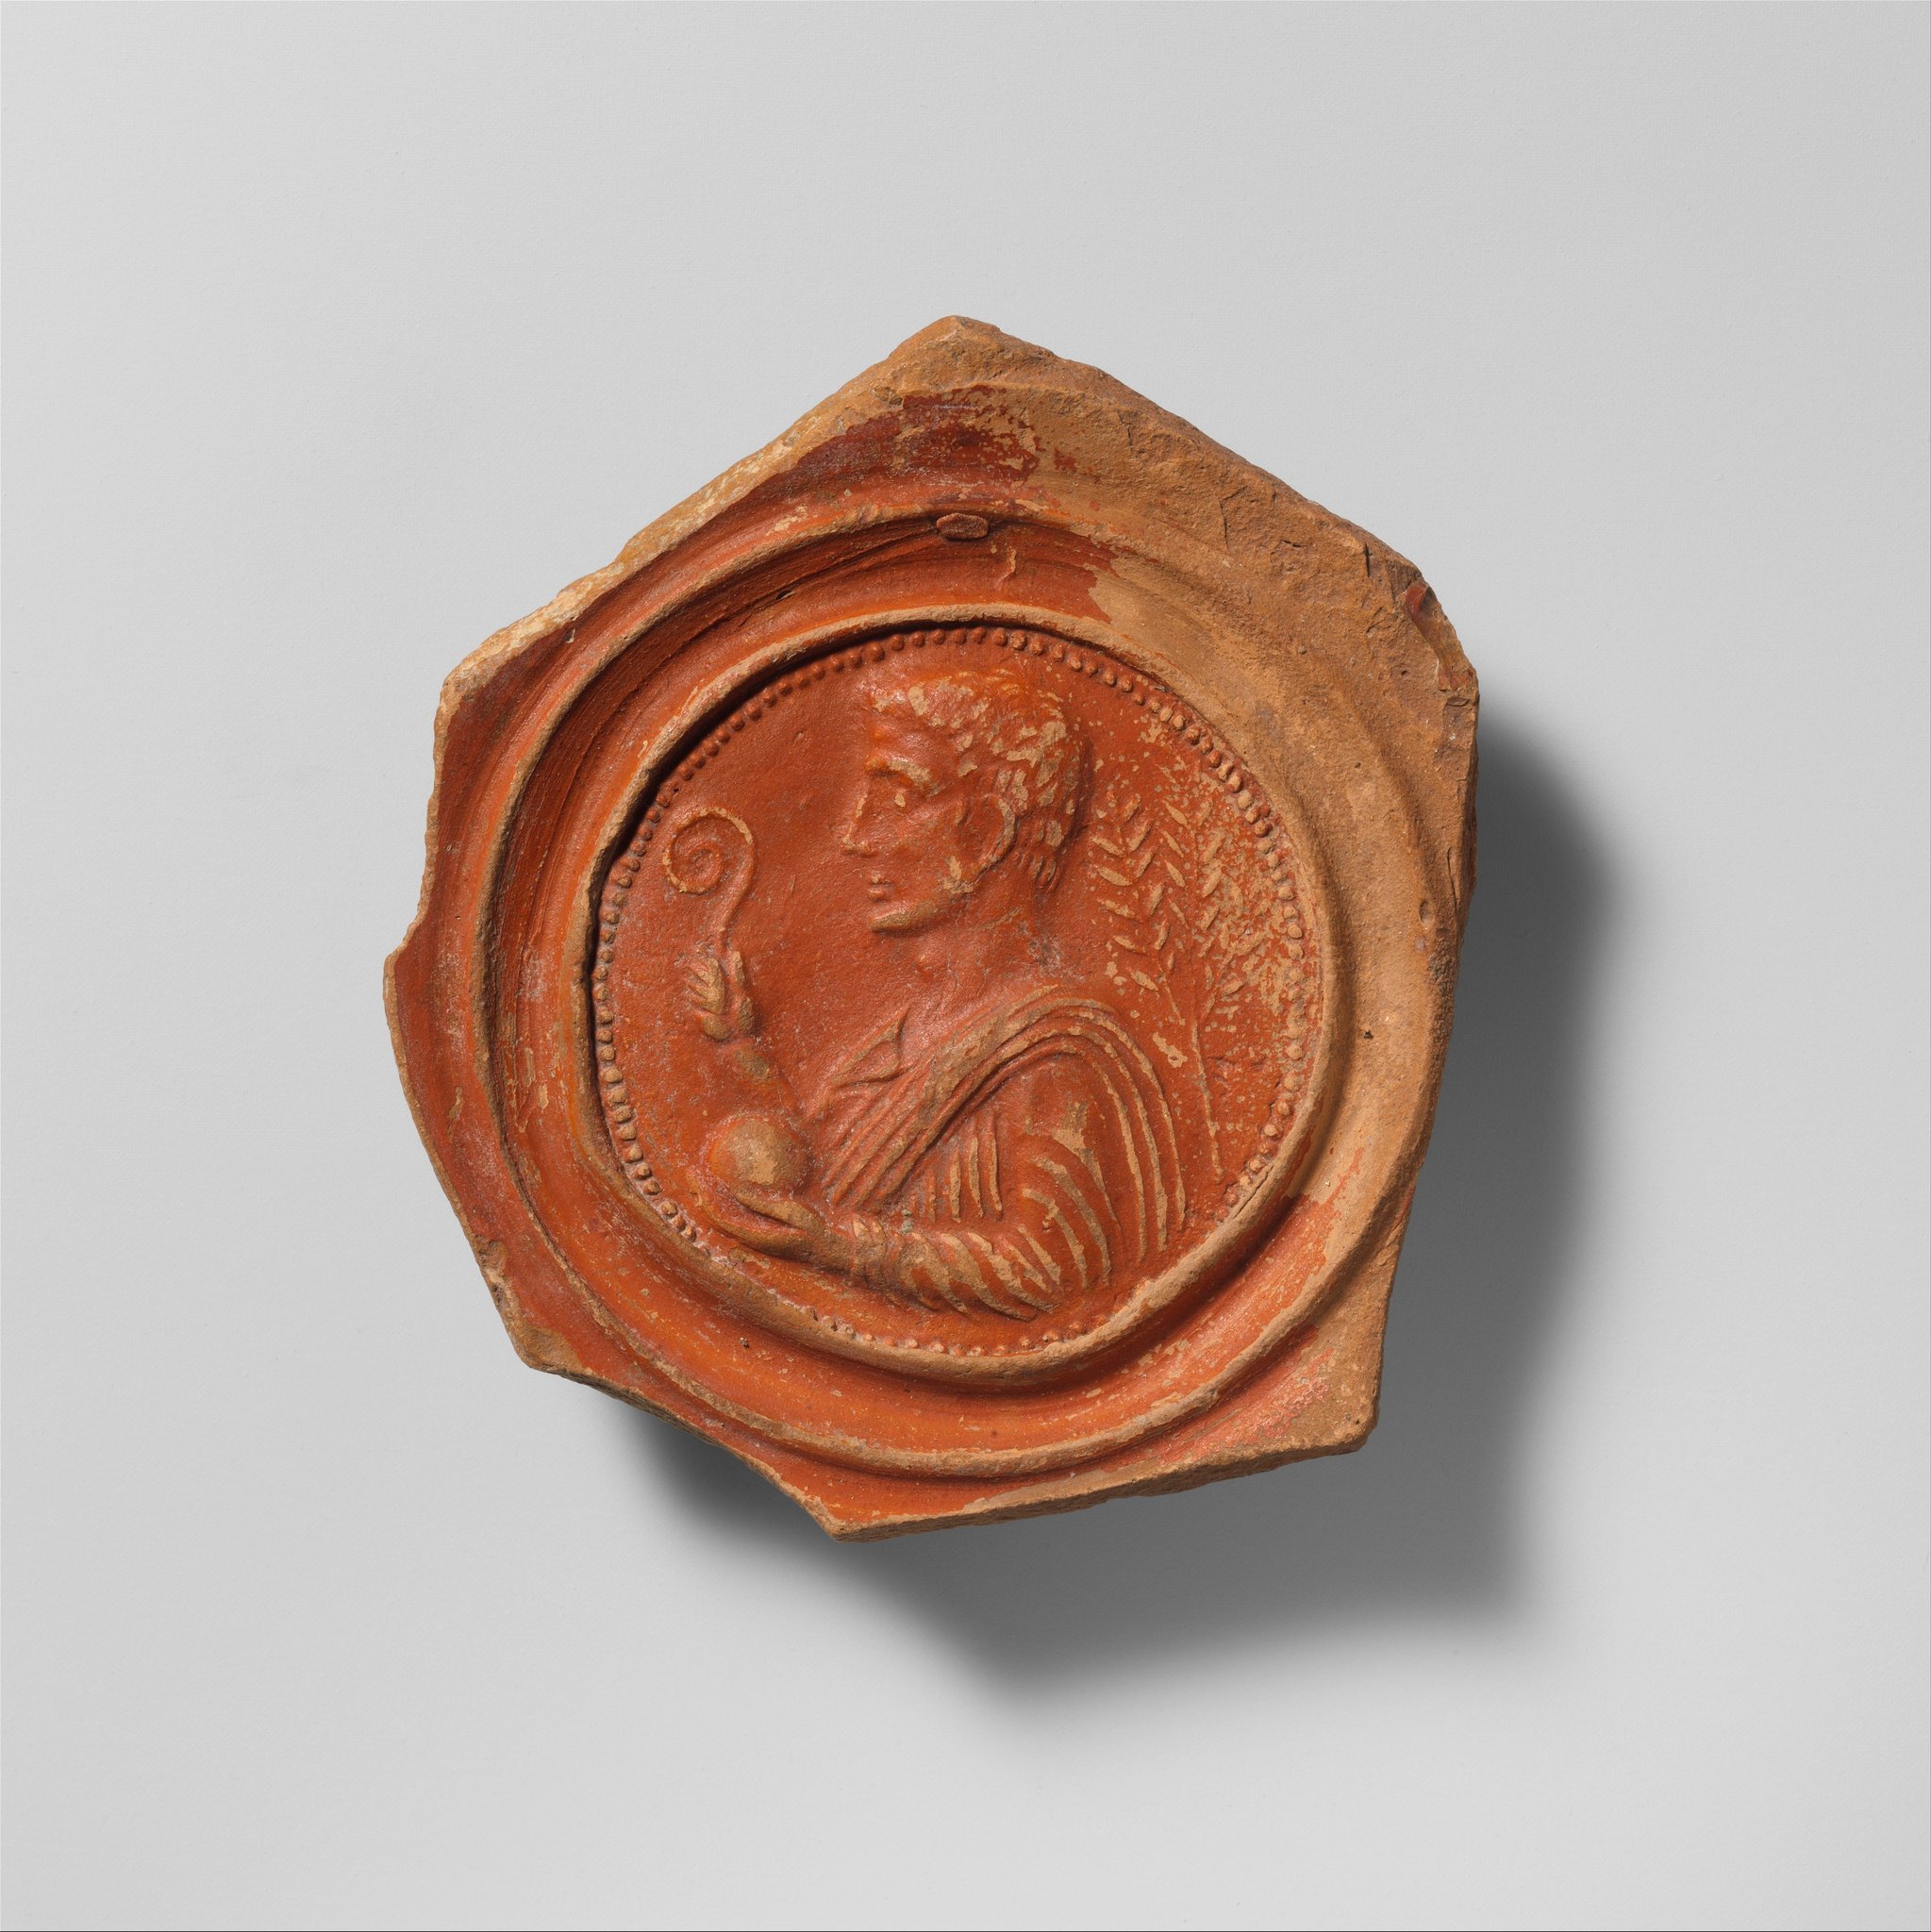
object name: vase fragment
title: Terracotta bowl fragment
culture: roman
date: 34 BCE-33 CE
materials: terracotta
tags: emperor augustus,portraits